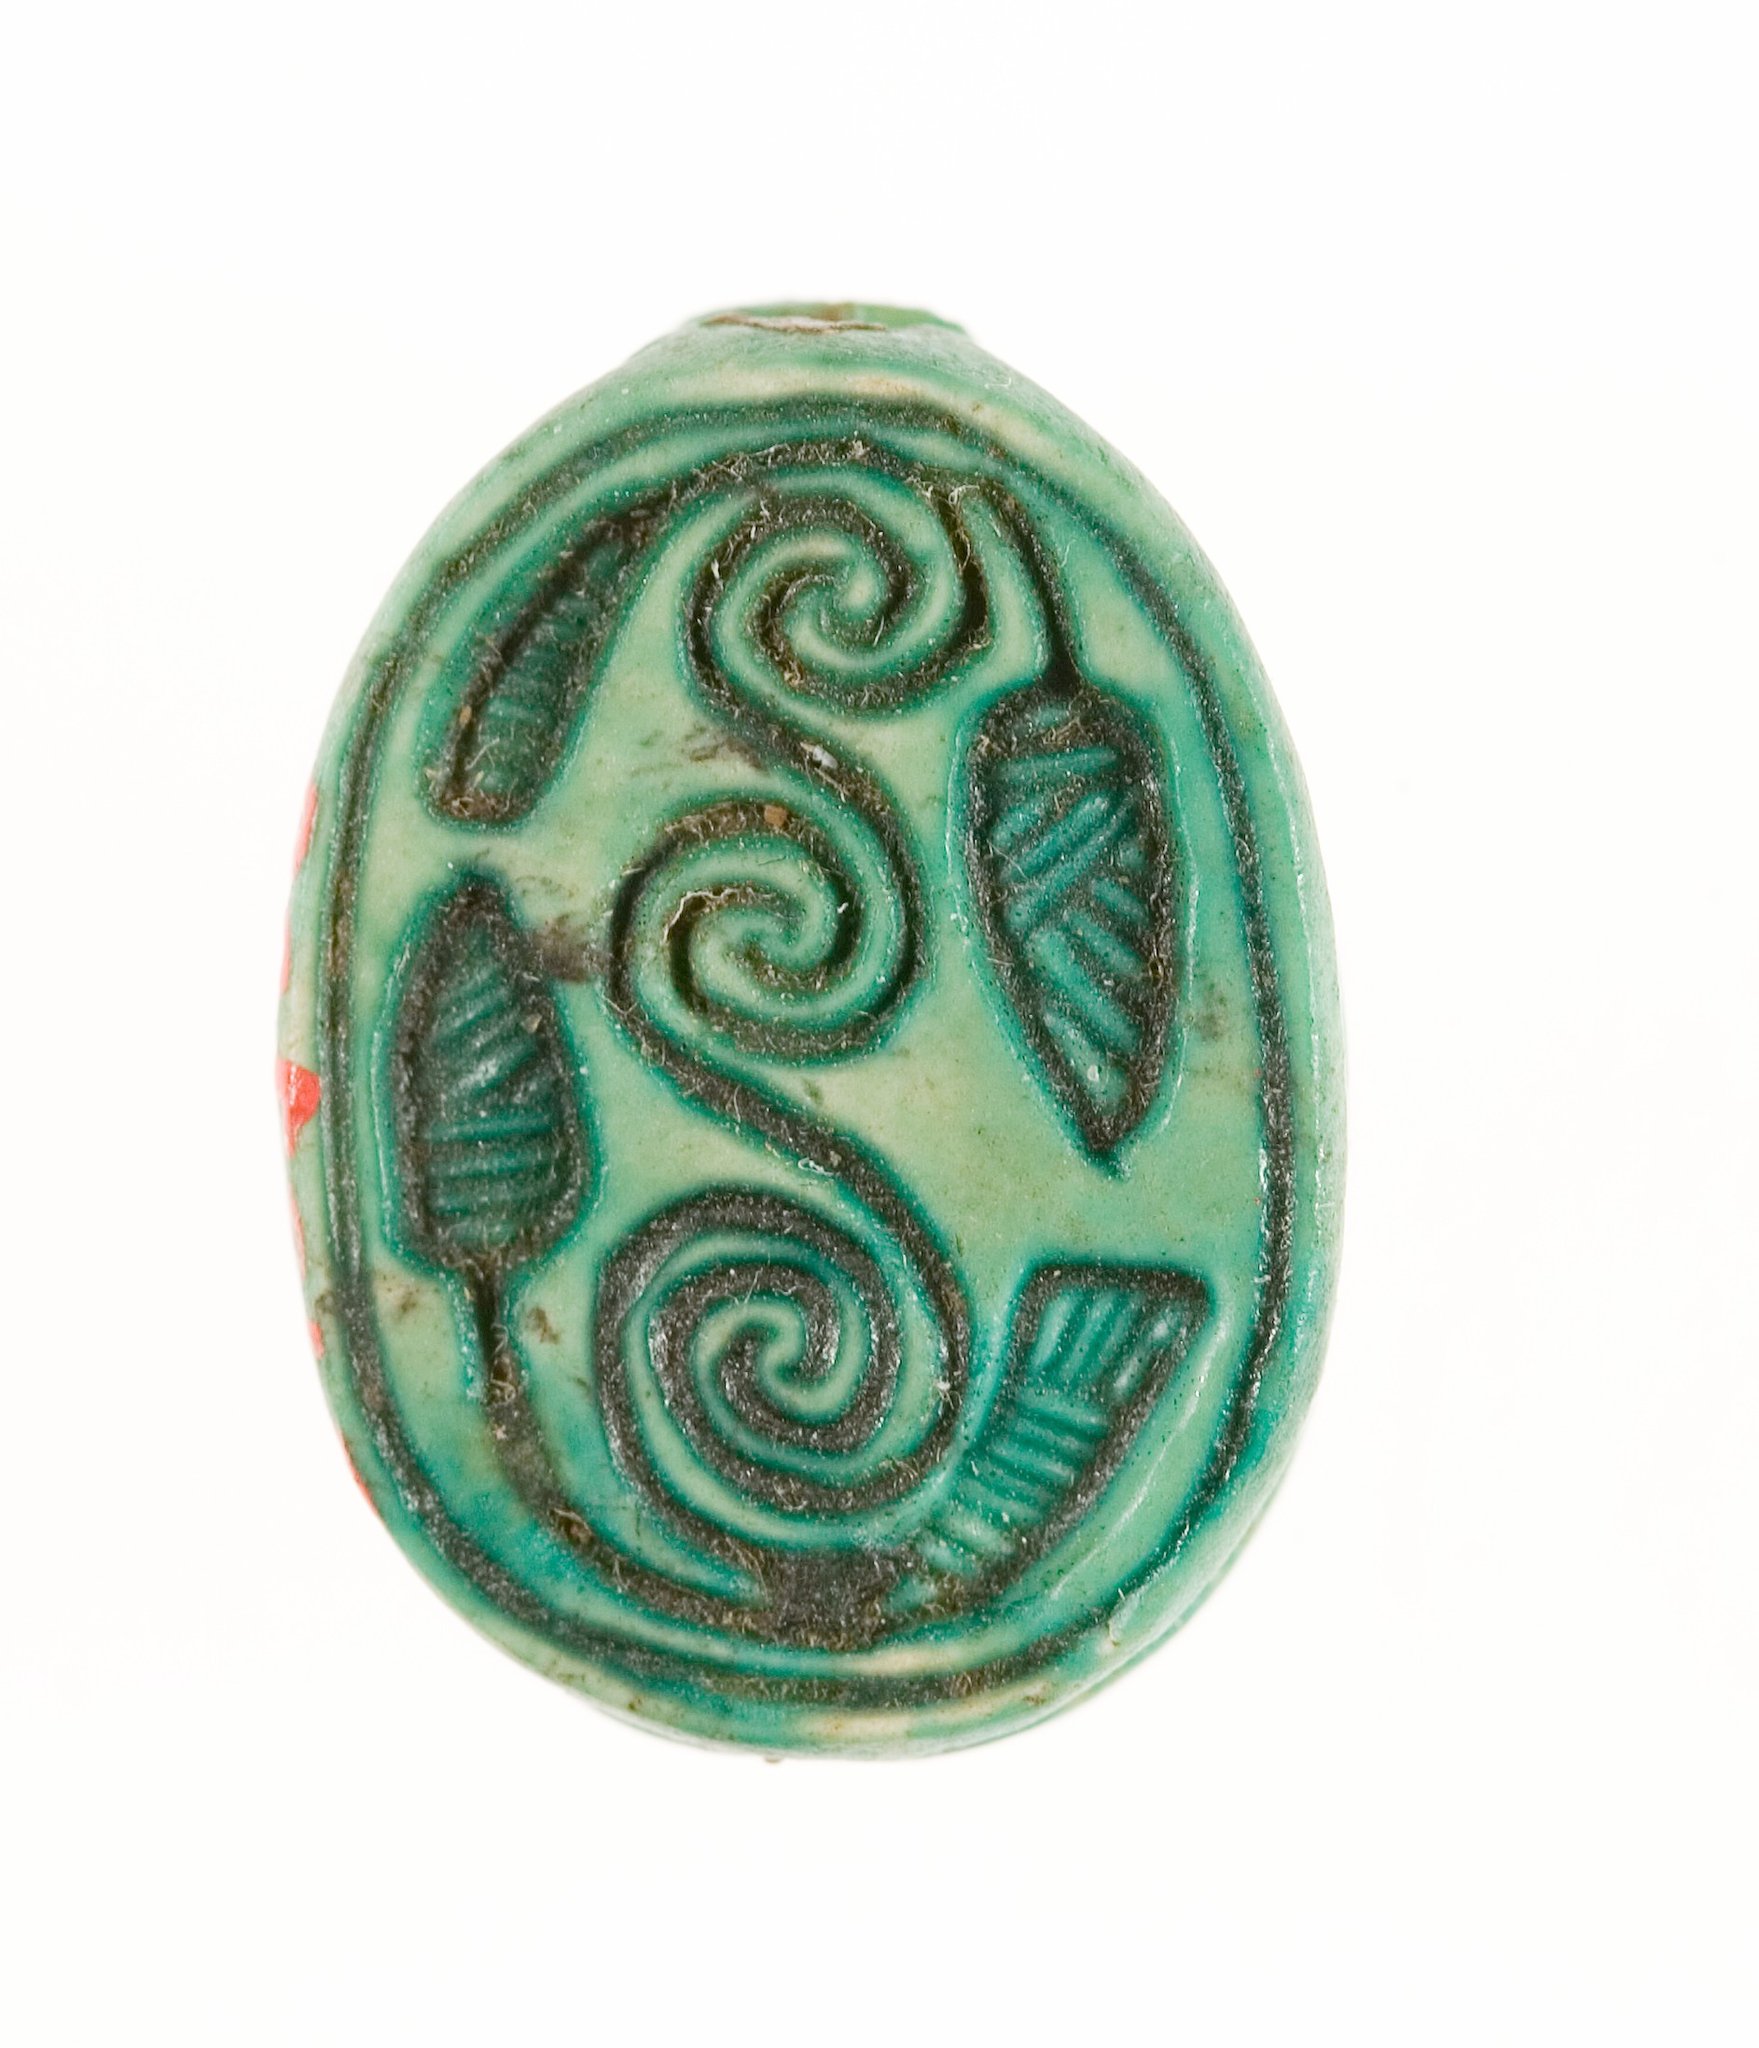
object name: scarab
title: Scarab Inscribed with a Geometric Pattern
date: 1479-1458 BCE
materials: stone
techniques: glazing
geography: egypt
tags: scarabs